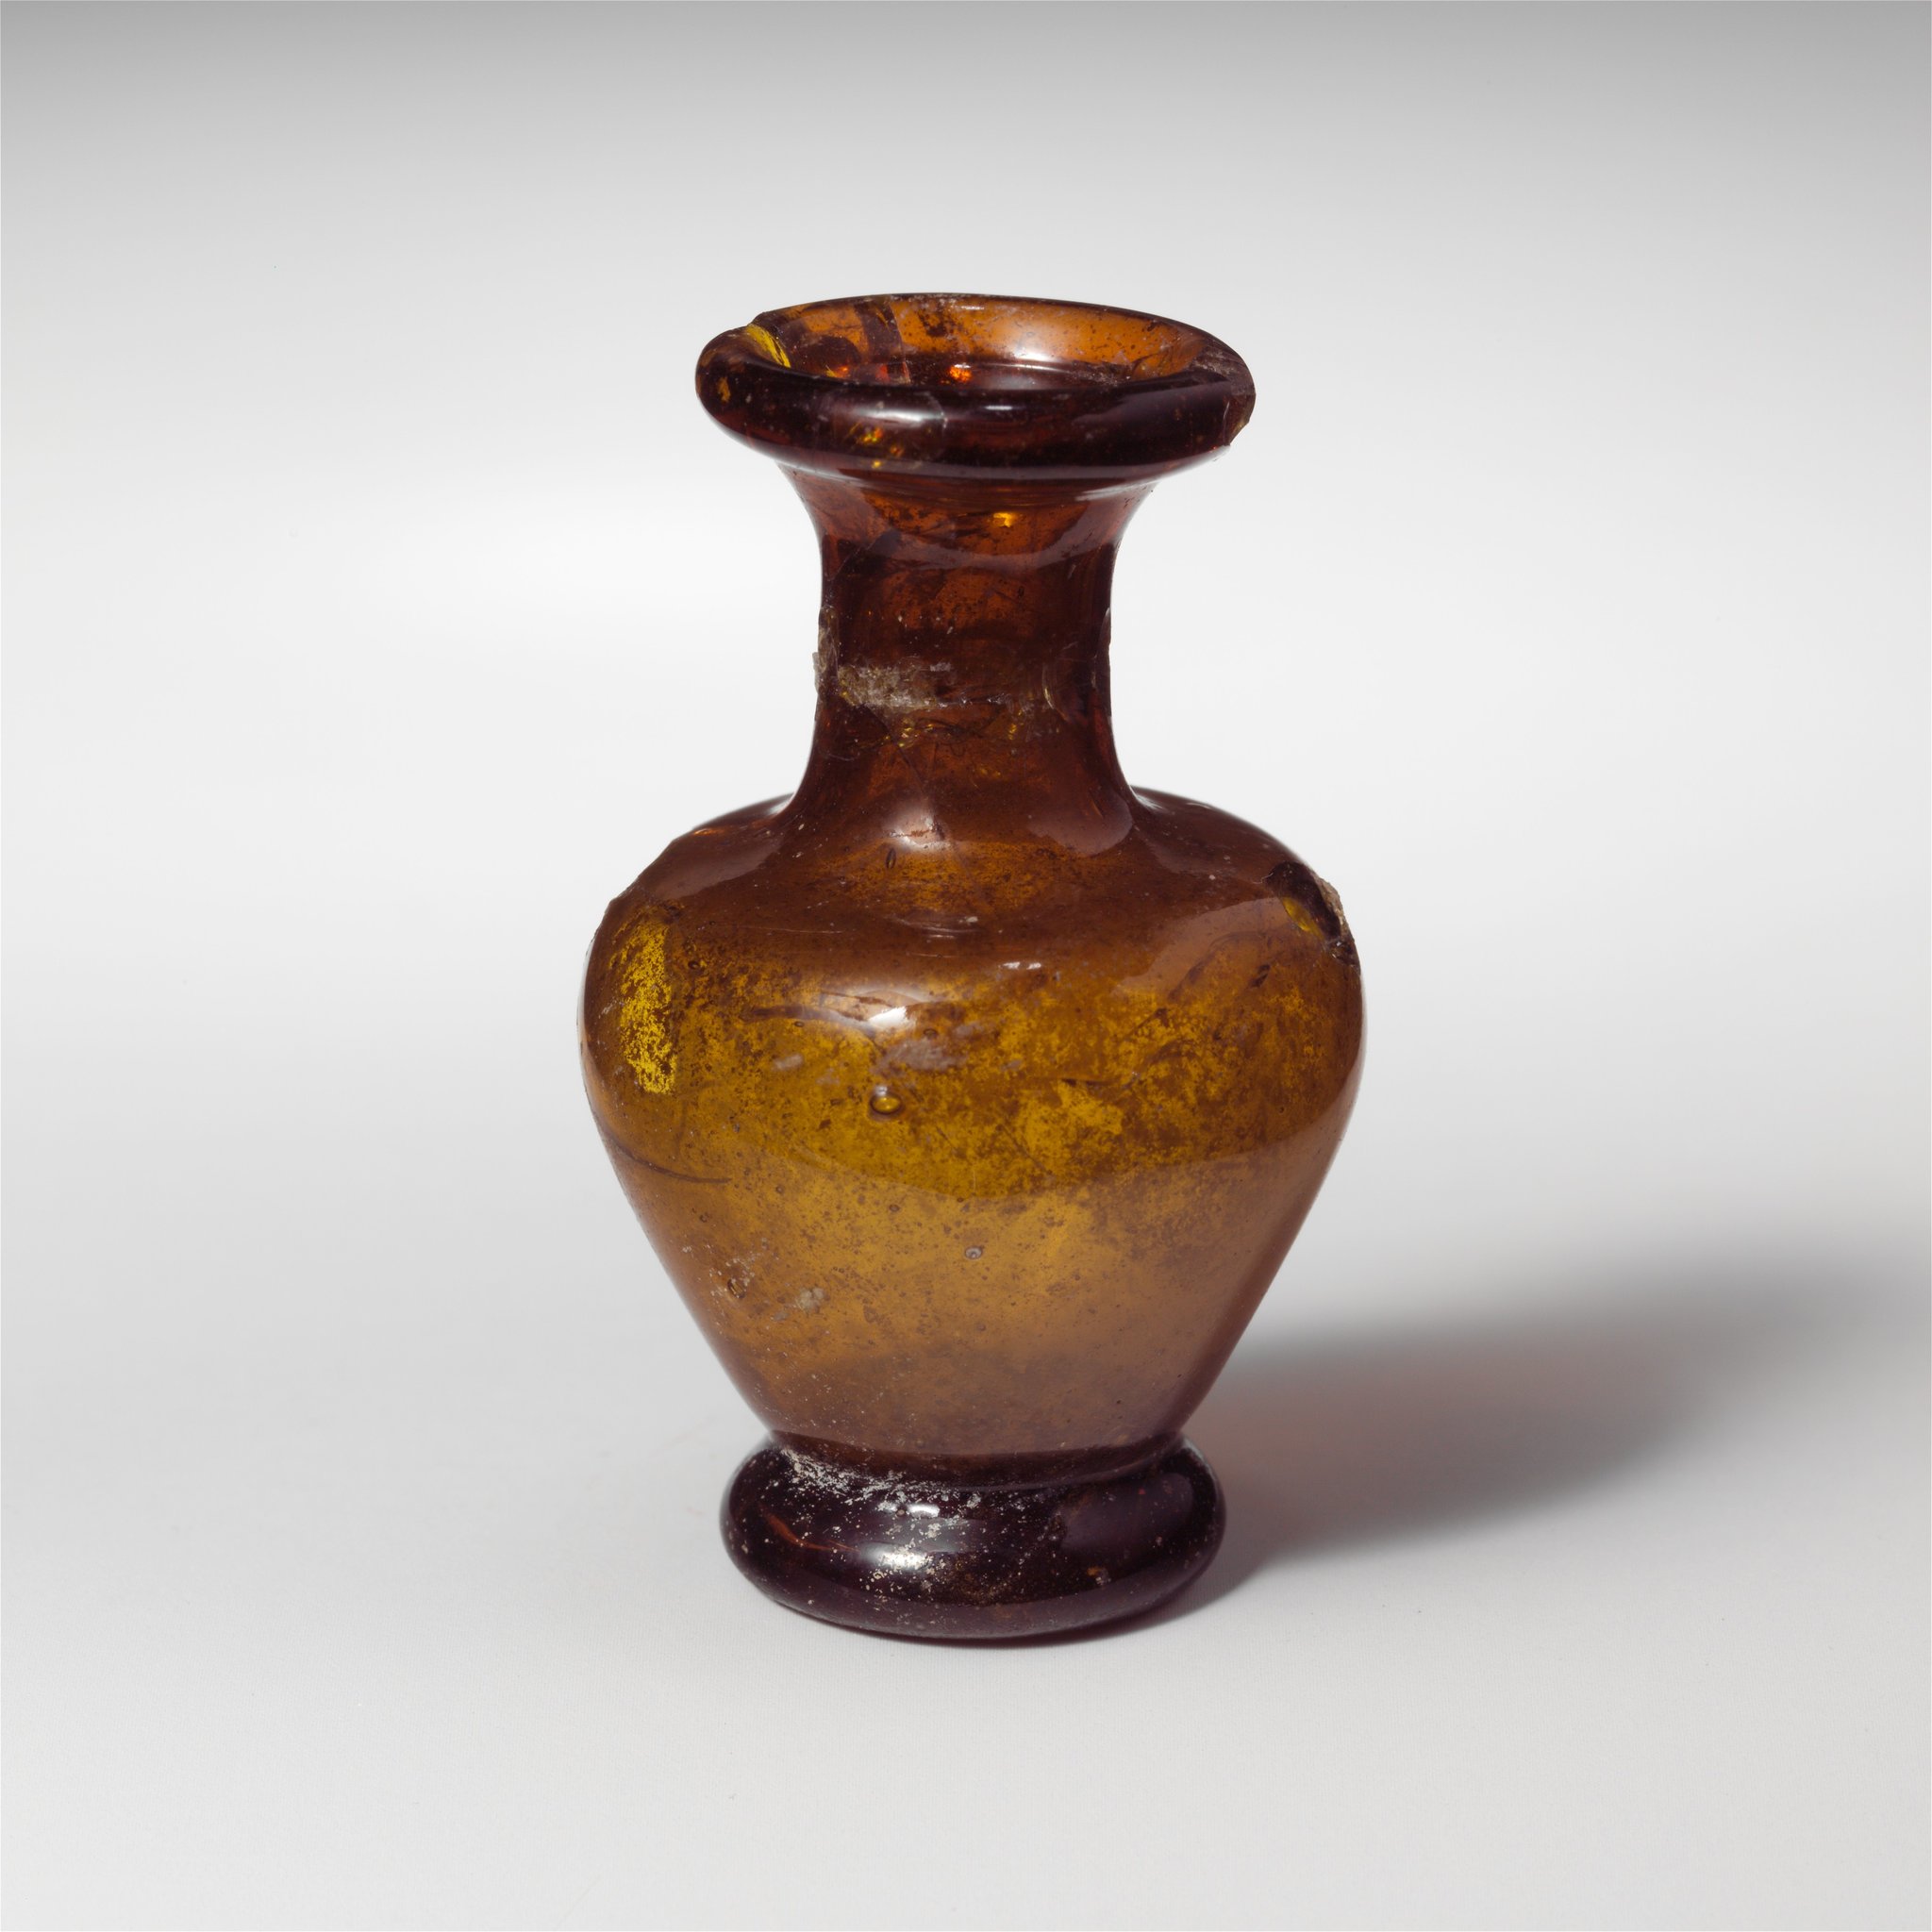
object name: bottle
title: Glass miniature bottle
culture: roman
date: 201-400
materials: glass